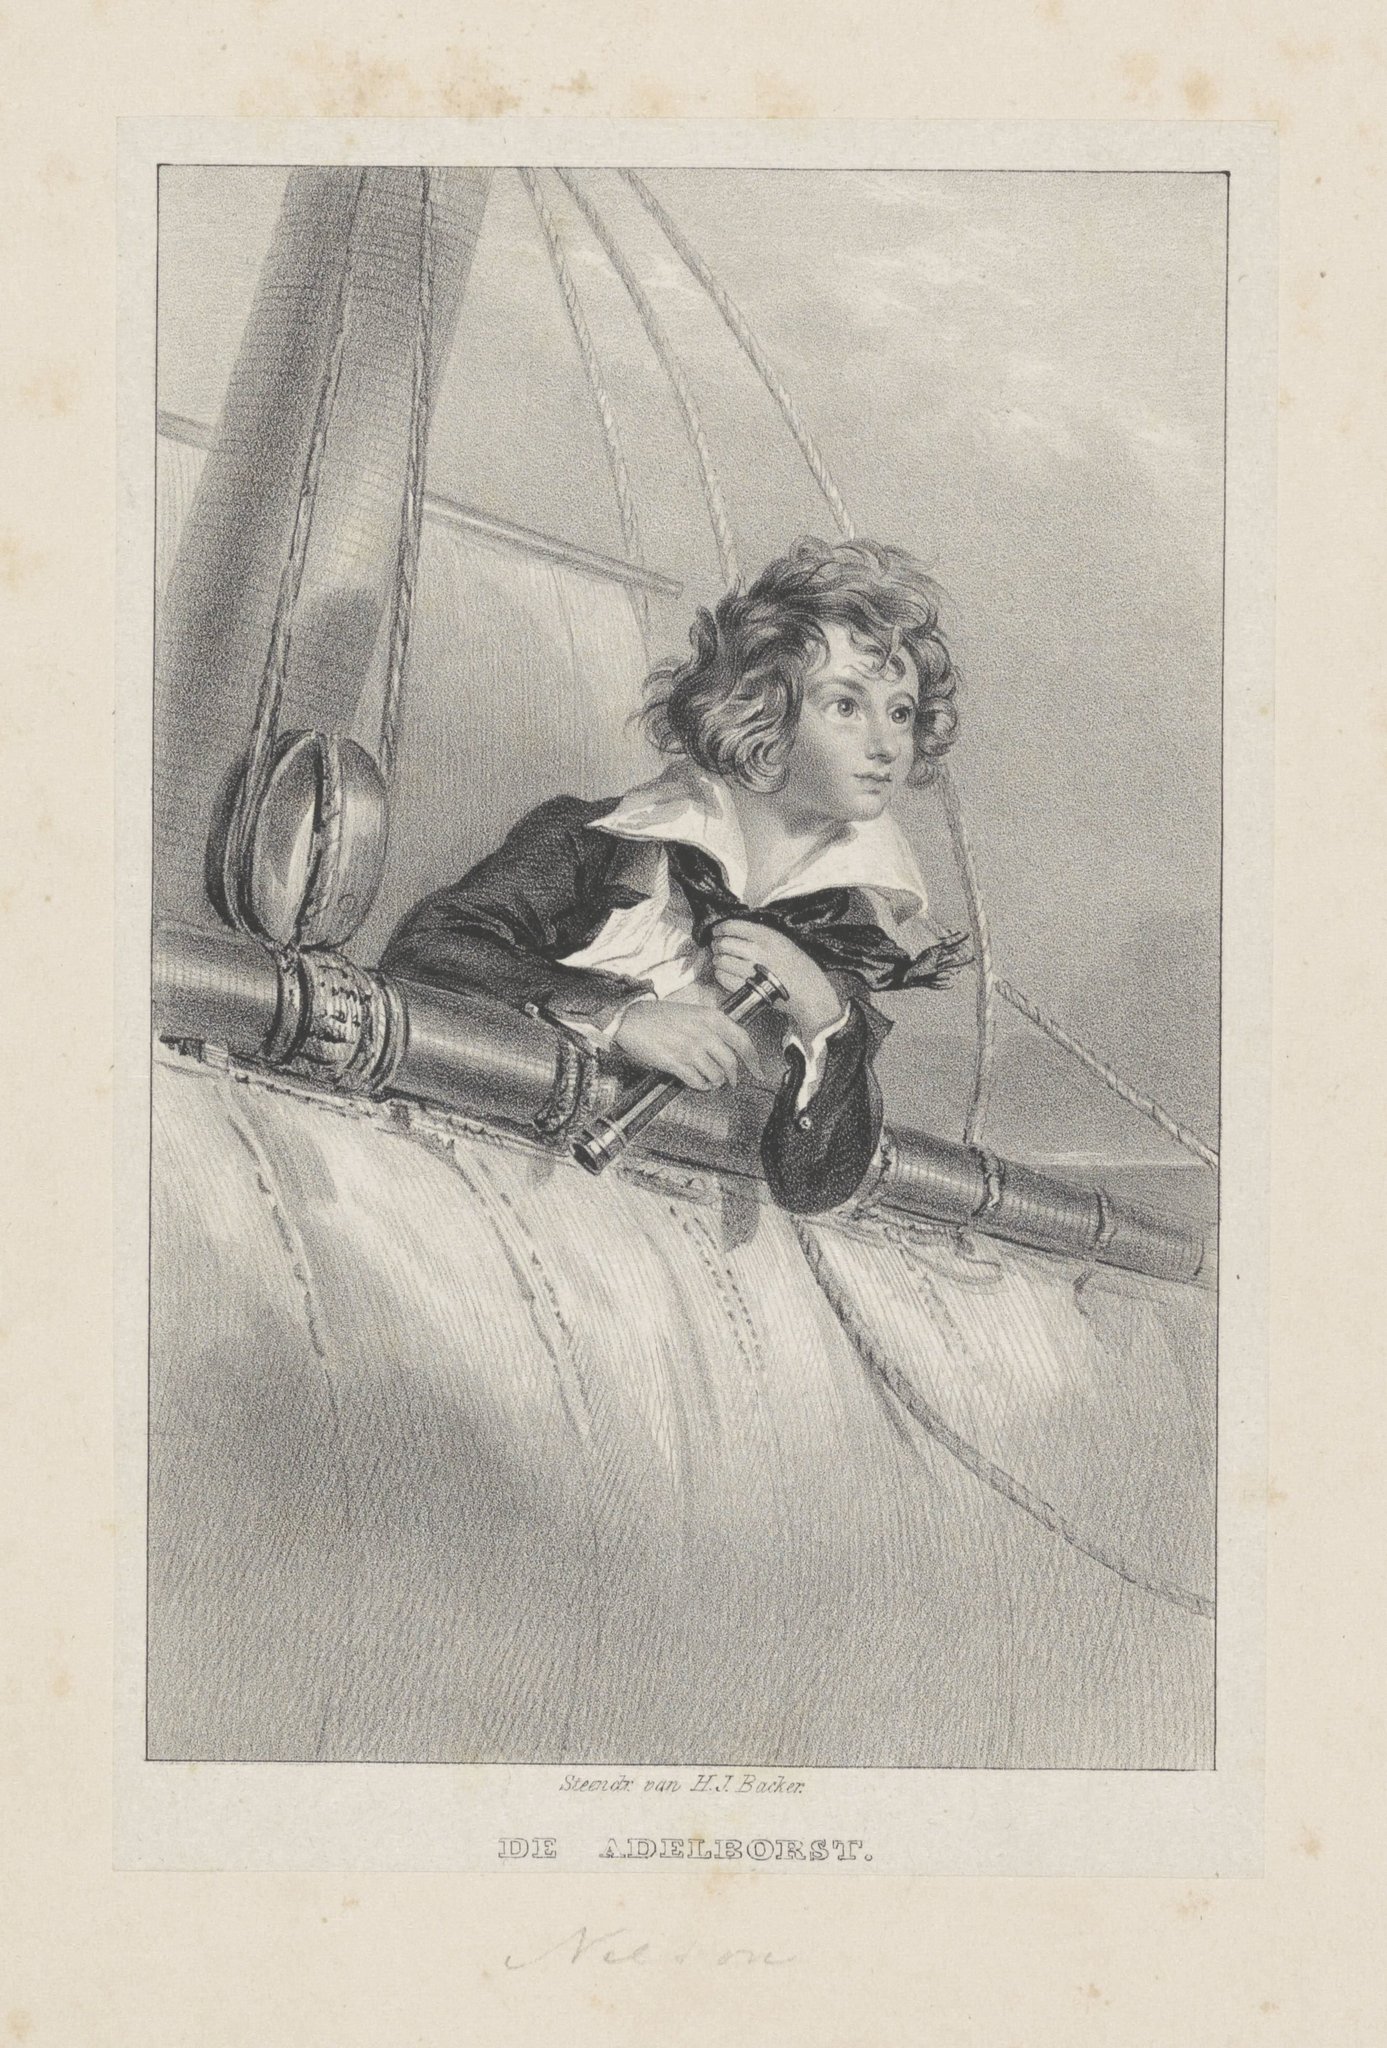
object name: print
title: Portret van een adelborst, waarschijnlijk admiraal Nelson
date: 1822-1845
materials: paper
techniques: lithograph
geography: dordrecht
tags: horatio nelson (hertog van bronte), sail, historical persons, binoculars, spy-glass, etc.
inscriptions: collector's mark: Lugt 2228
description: De geportretteerde staat op een schip en hangt over de rand van een gestreken zeil met de wind in zijn rug. In zijn hand heeft hij een verrekijker. Onder het portret de woorden: De Adelborst.